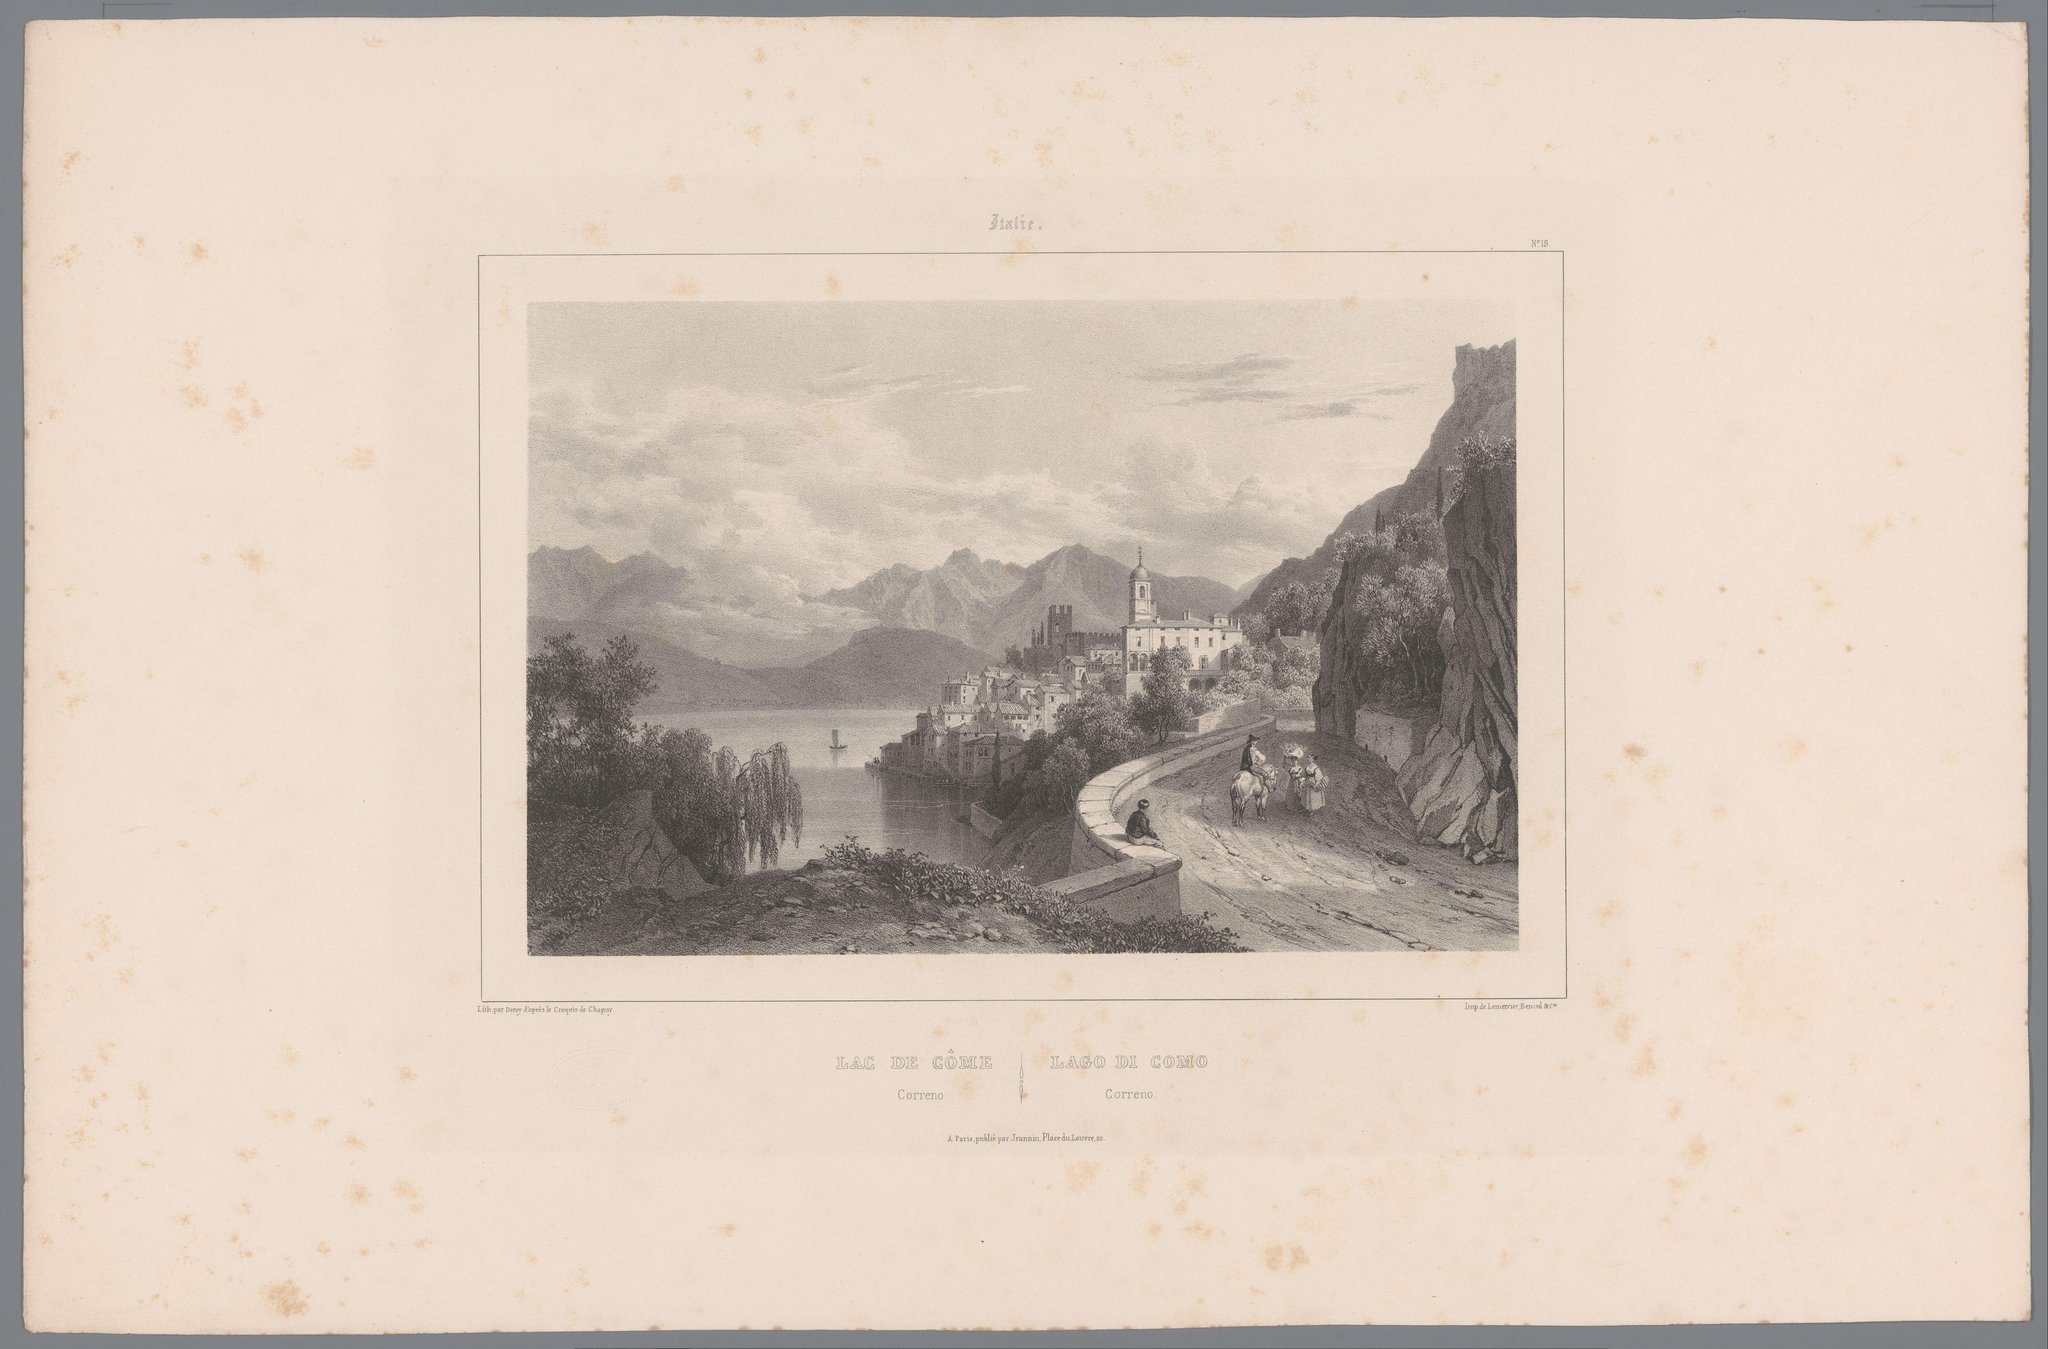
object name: print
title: Italie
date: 1838-1841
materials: paper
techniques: lithograph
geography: paris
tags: prospect of village, silhouette of village, mountains (+ landscape with figures, staffage), lake (+ landscape with figures, staffage)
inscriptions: check stamp: Lugt 1397c, collector's mark: Lugt 2228a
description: Prent maakt deel uit van een omslag met zes prenten.